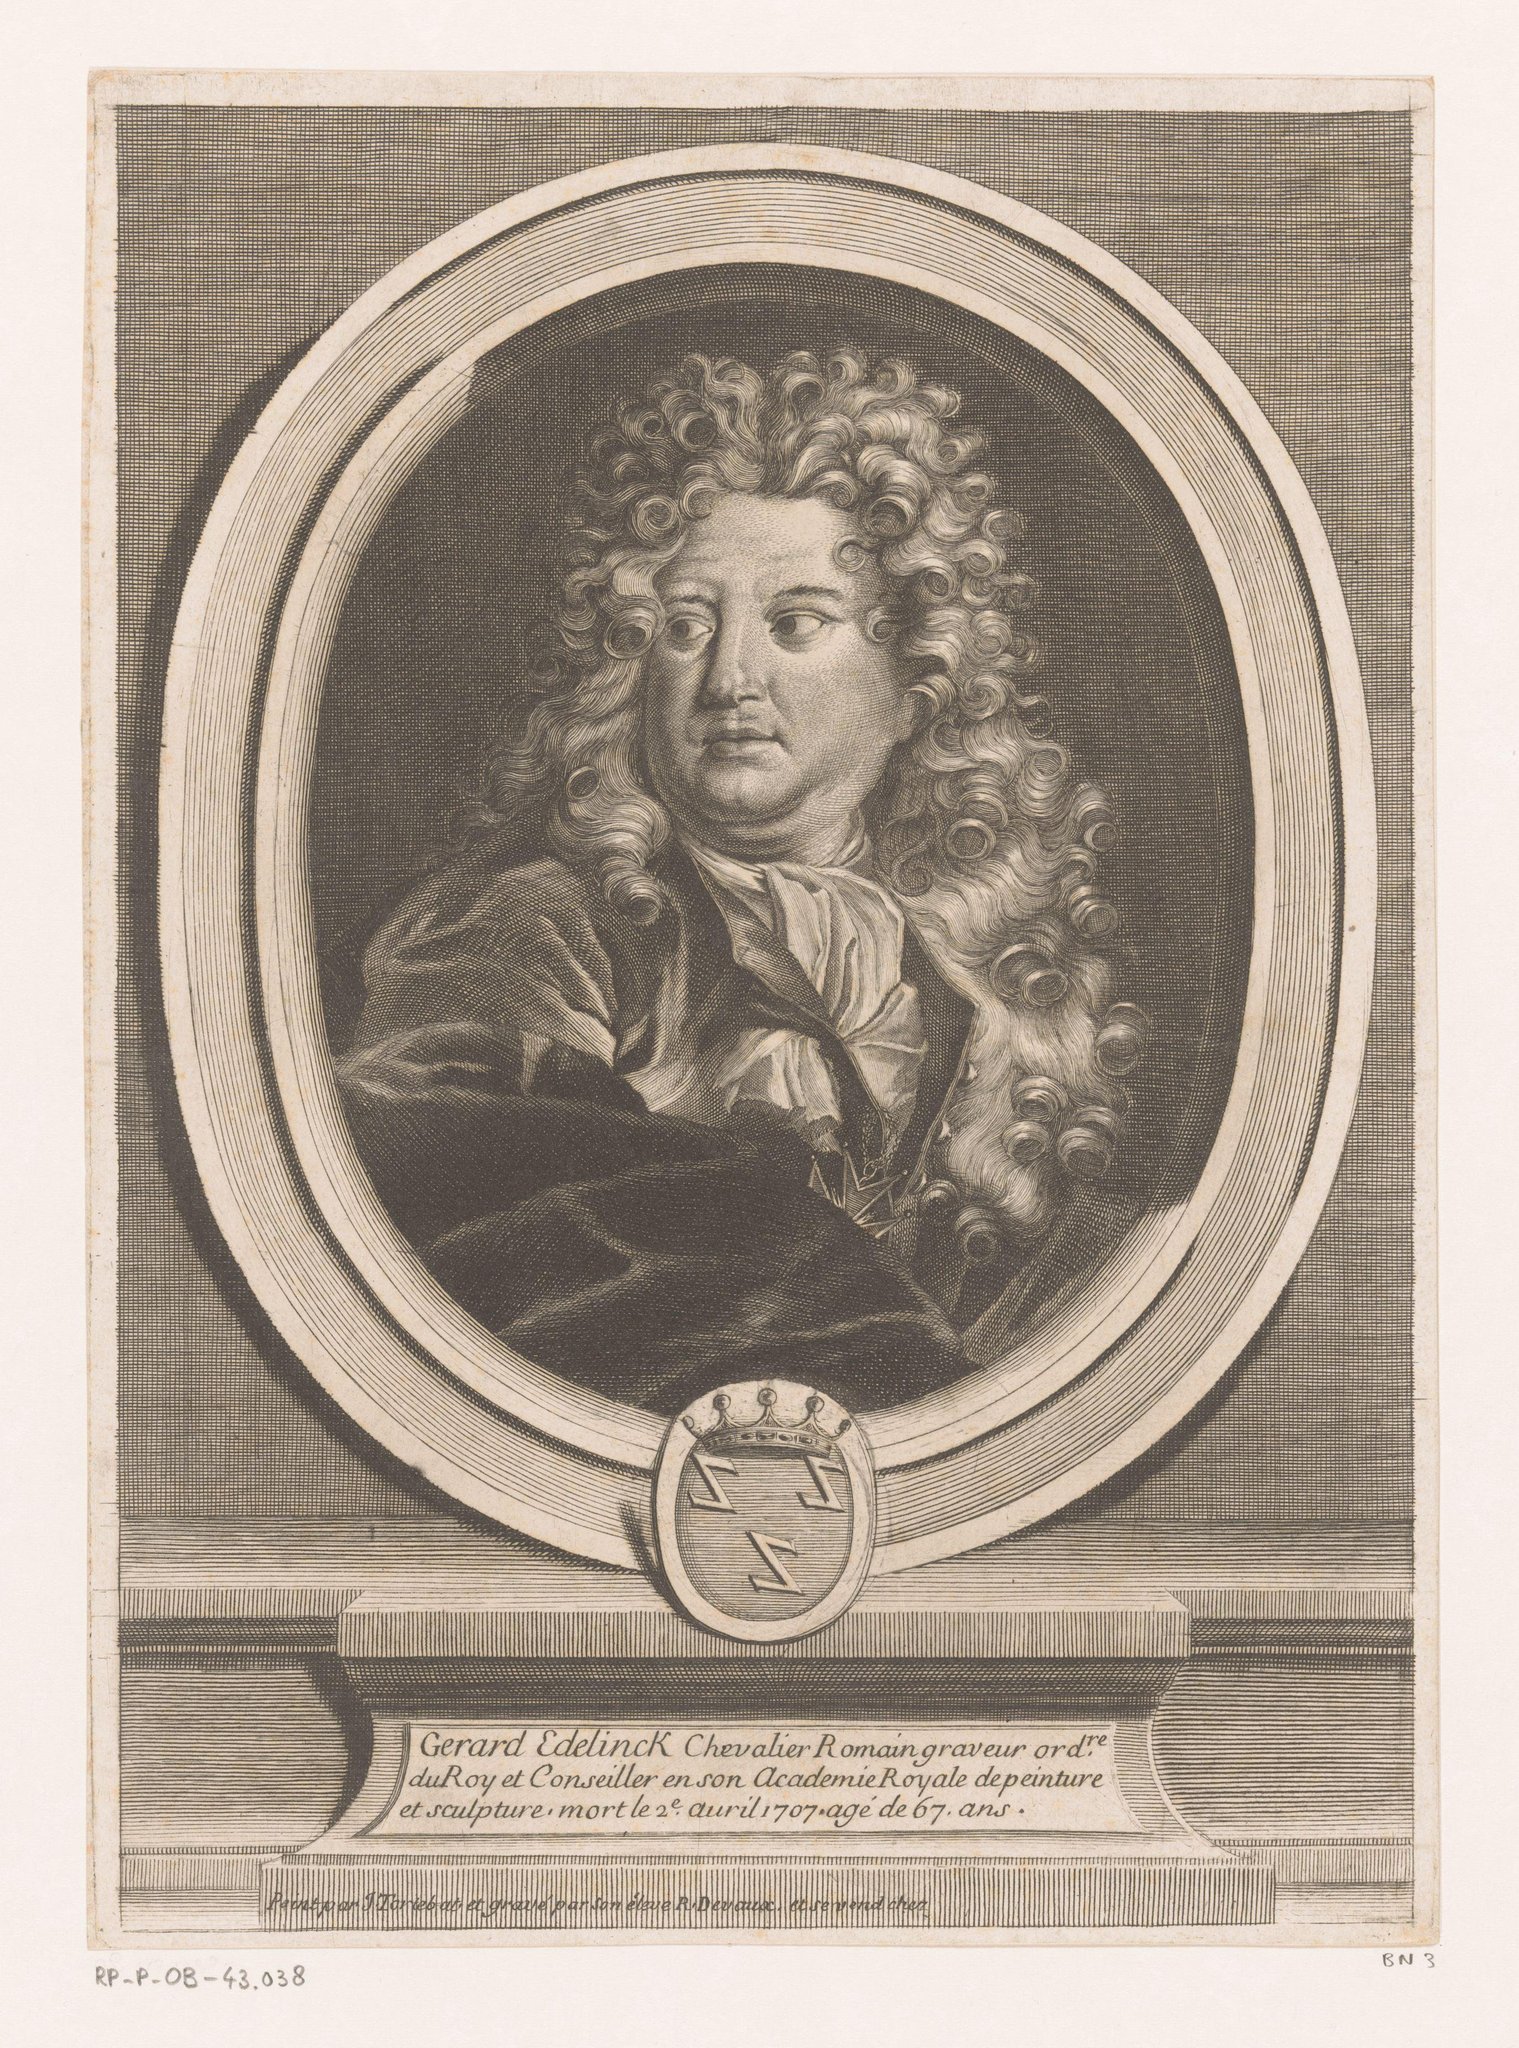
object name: print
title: Portret van Gerard Edelinck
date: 1695-1705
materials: paper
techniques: engraving, etching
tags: antwerp, gerard edelinck, historical persons, portrait, self-portrait of graphic artist, armorial bearing, heraldry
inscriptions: collector's mark: Lugt 240